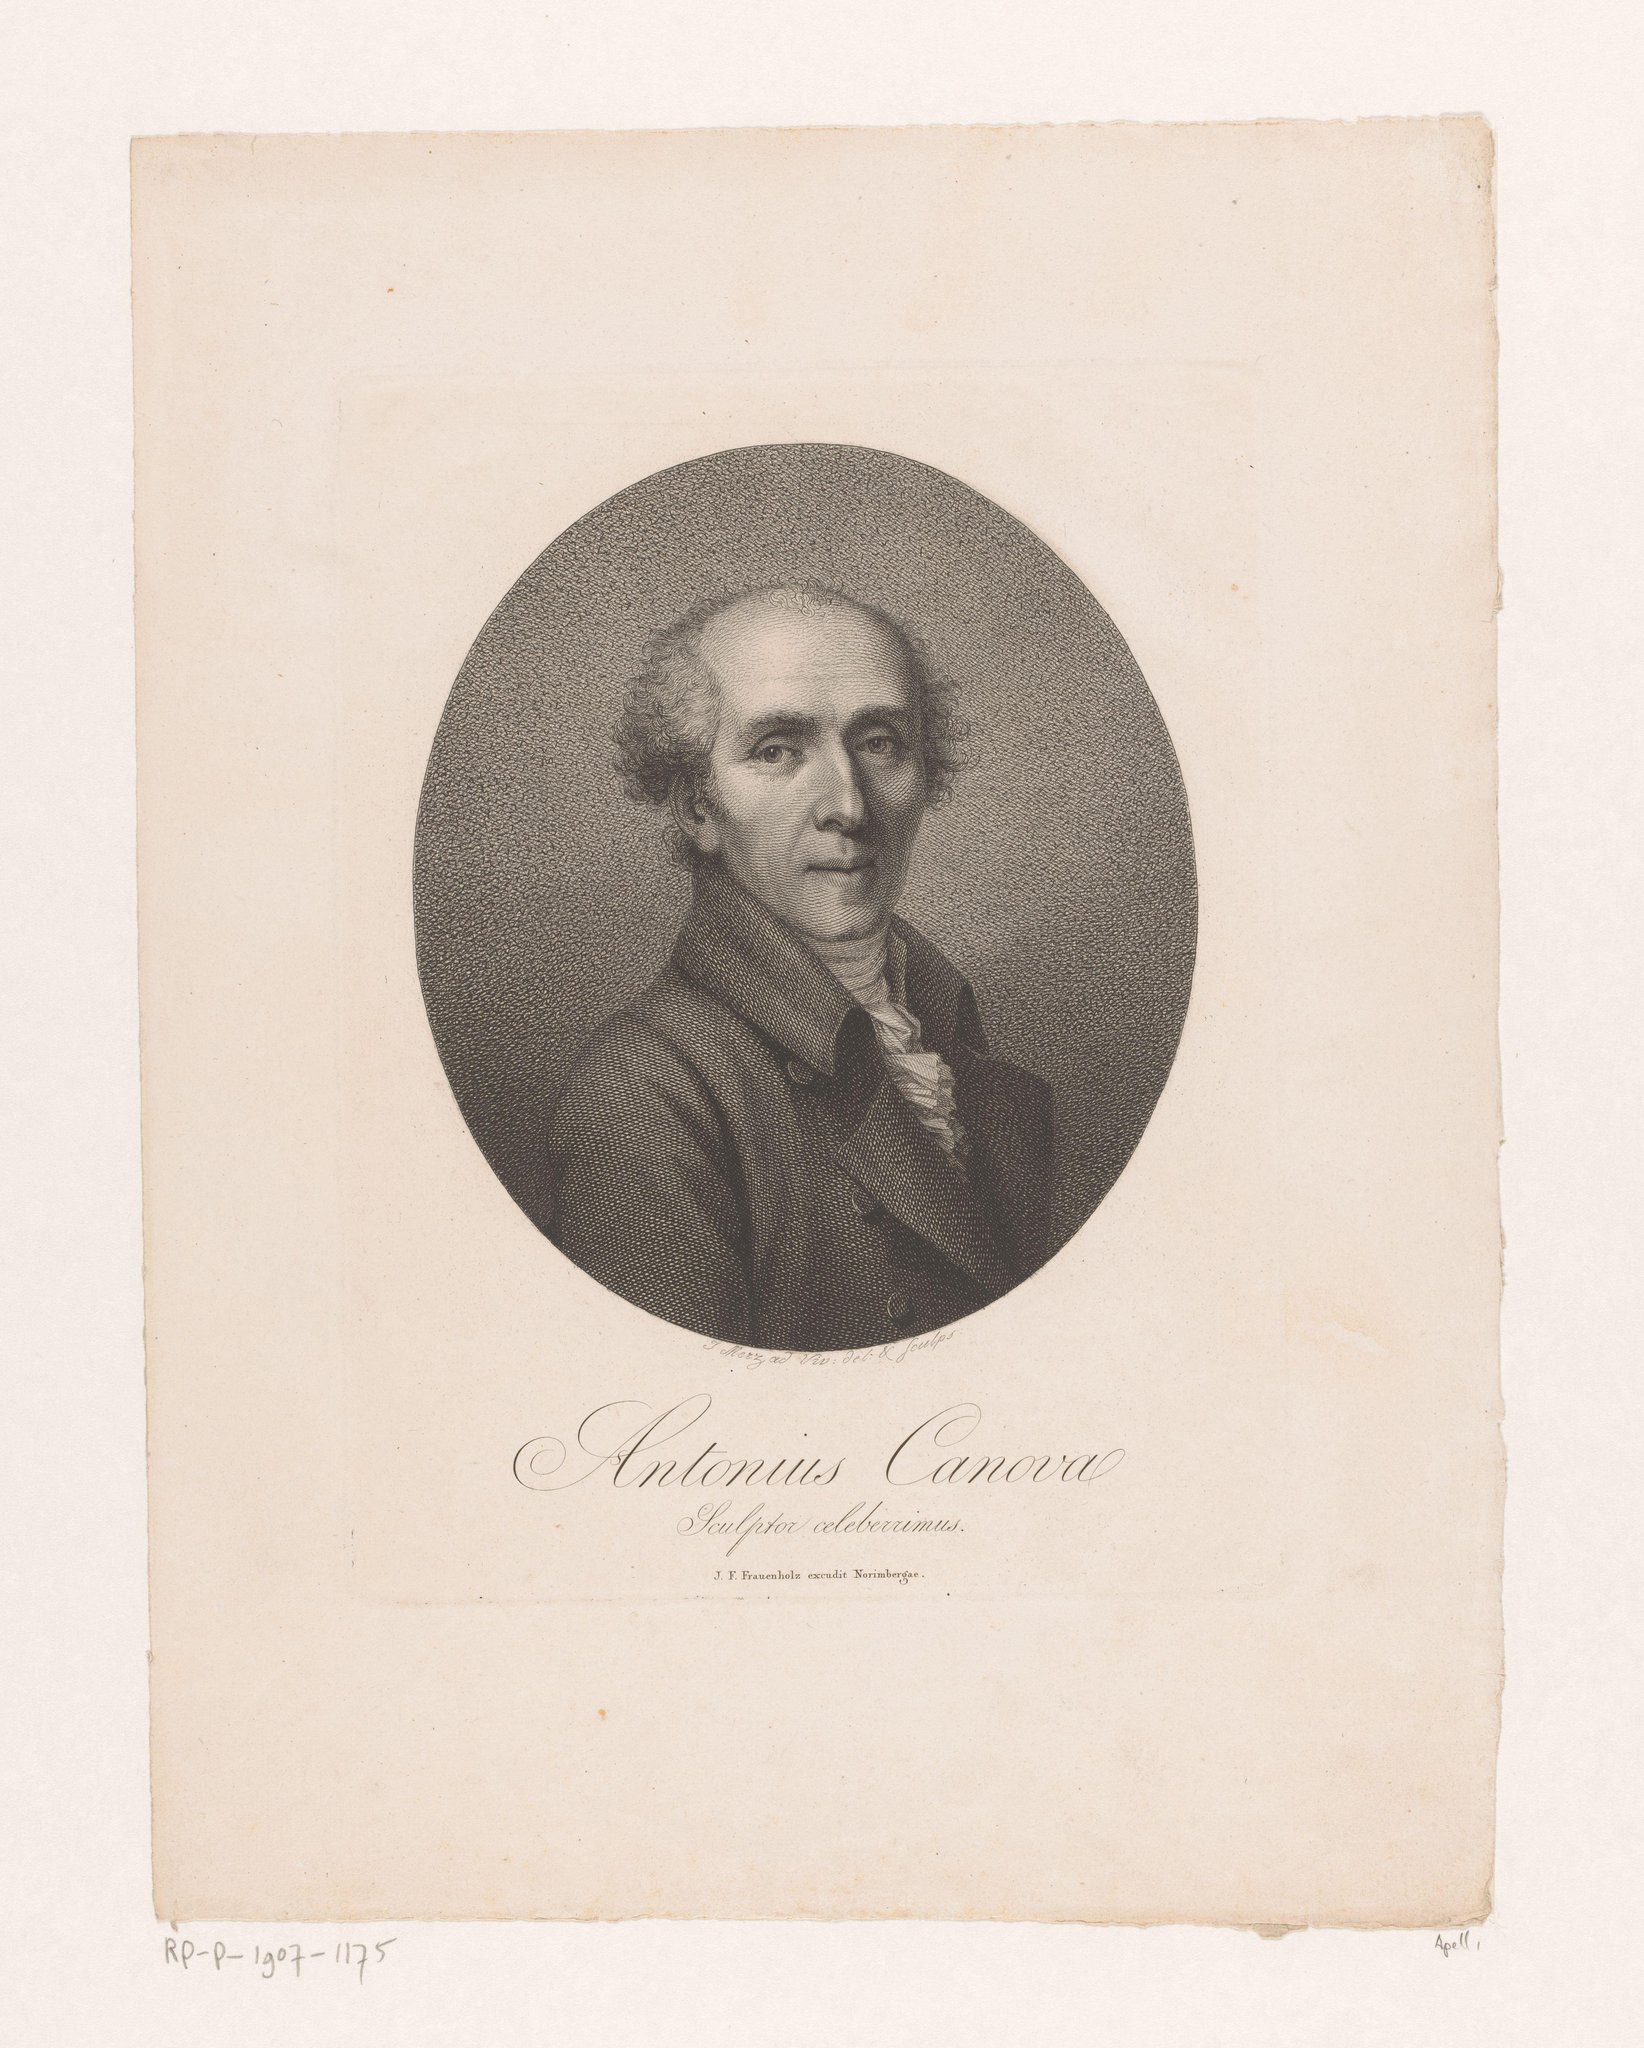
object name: print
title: Portret van Antonio Canova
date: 1805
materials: paper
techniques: etching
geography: nuremberg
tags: antonio canova, portrait, self-portrait of sculptor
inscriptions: collector's mark: Lugt 2228